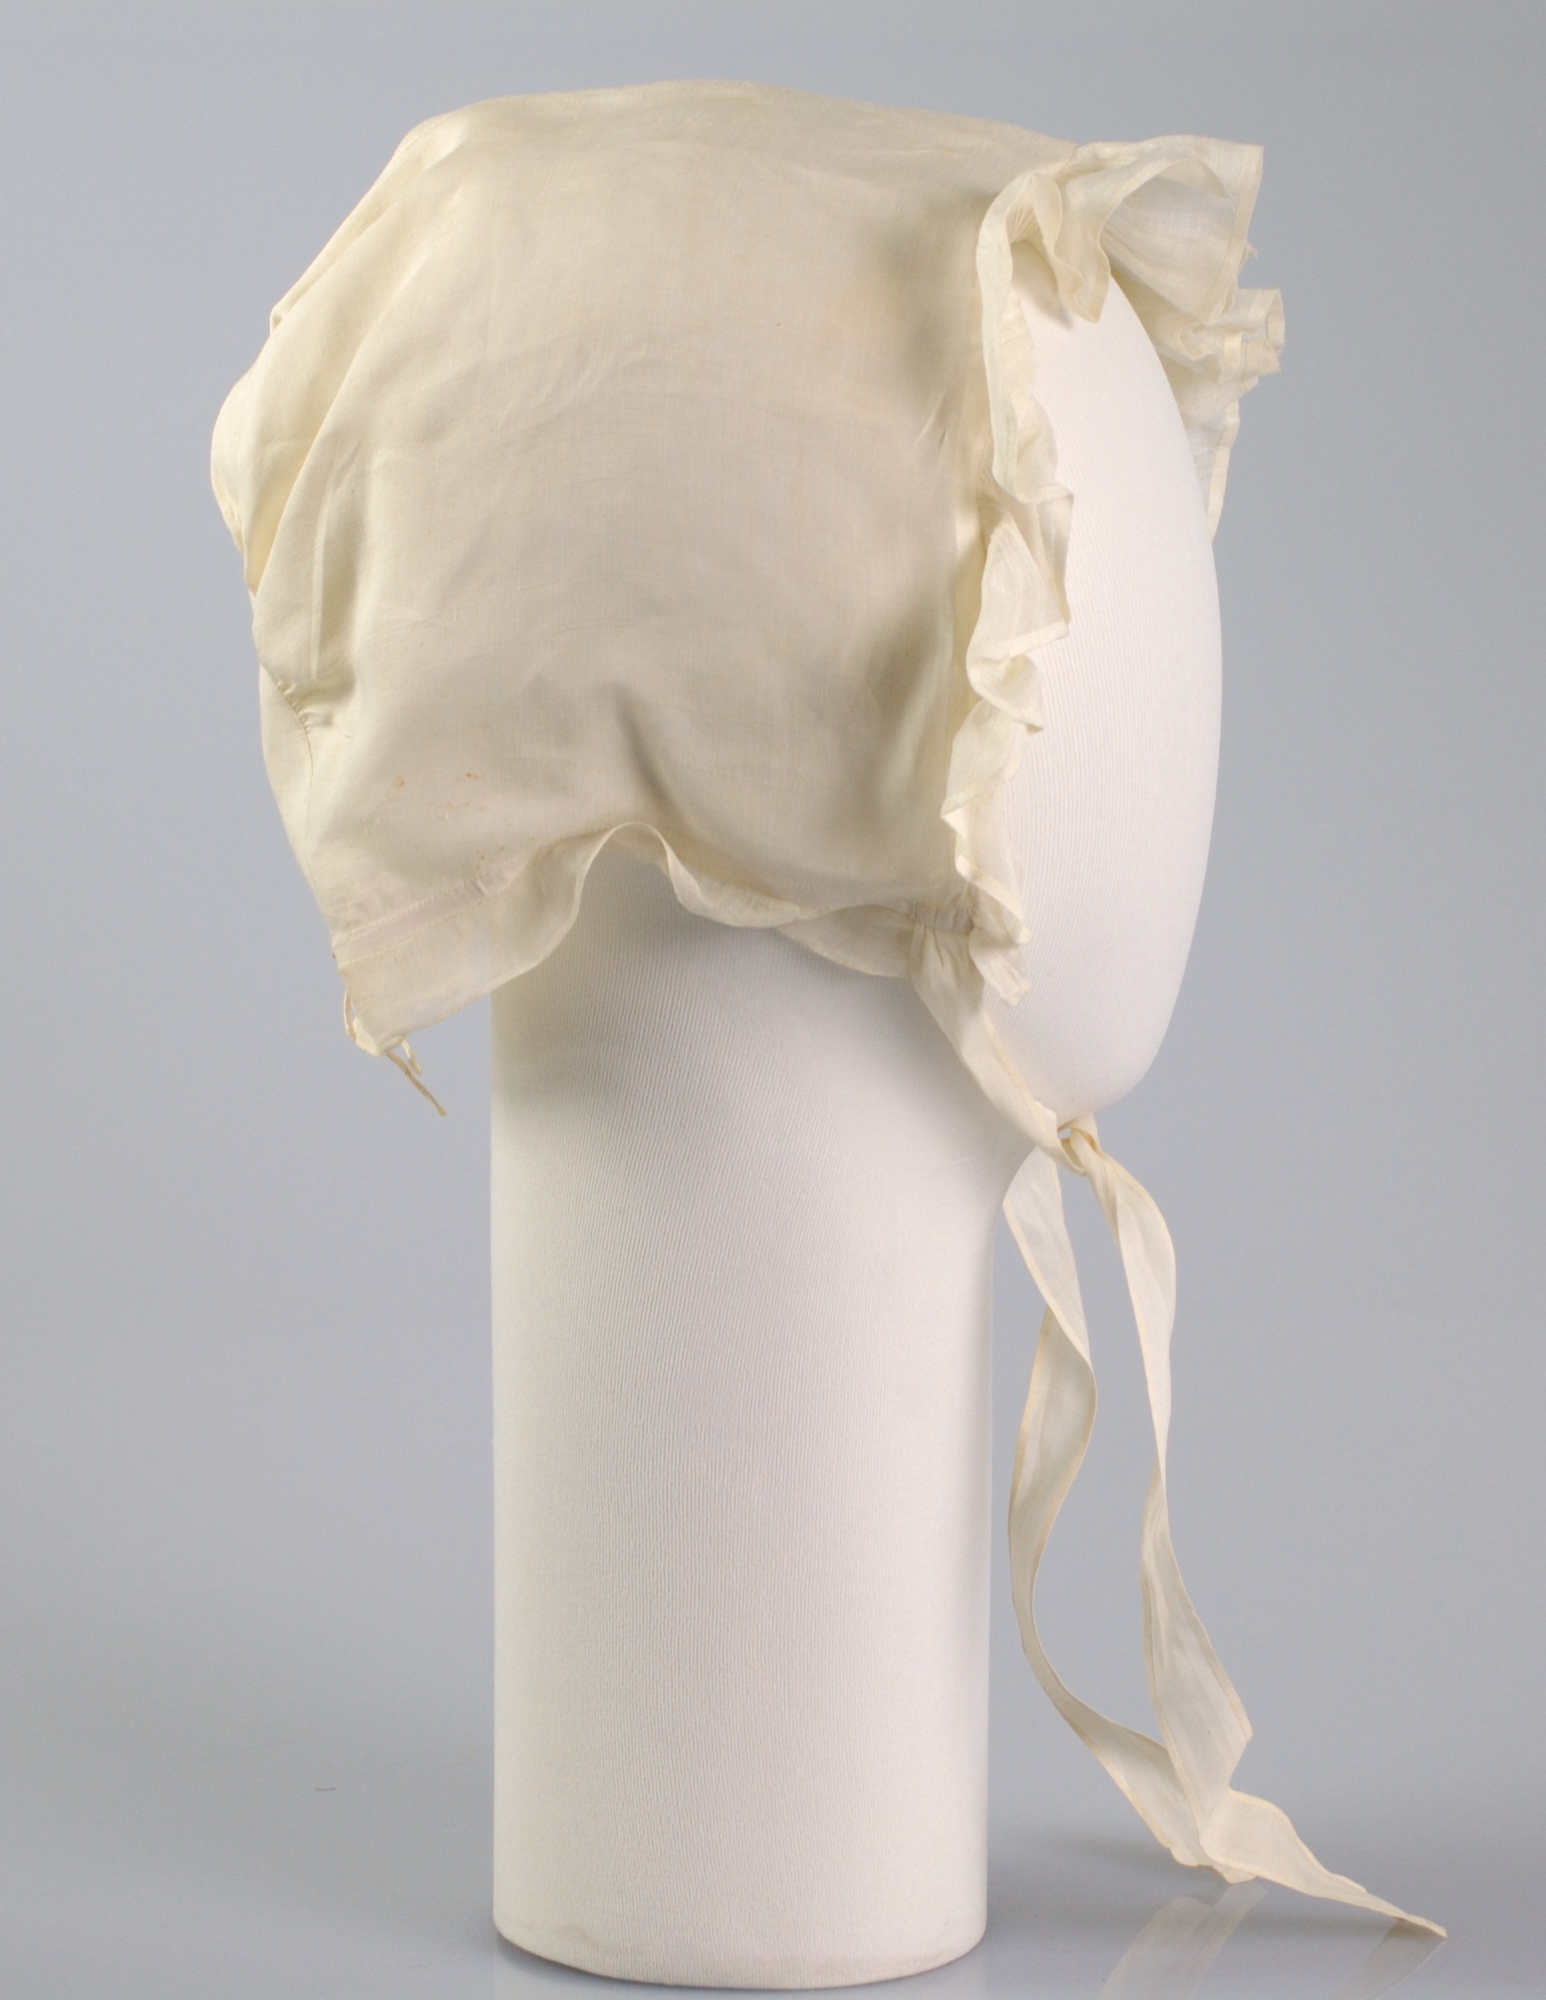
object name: cap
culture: american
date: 1825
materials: linen